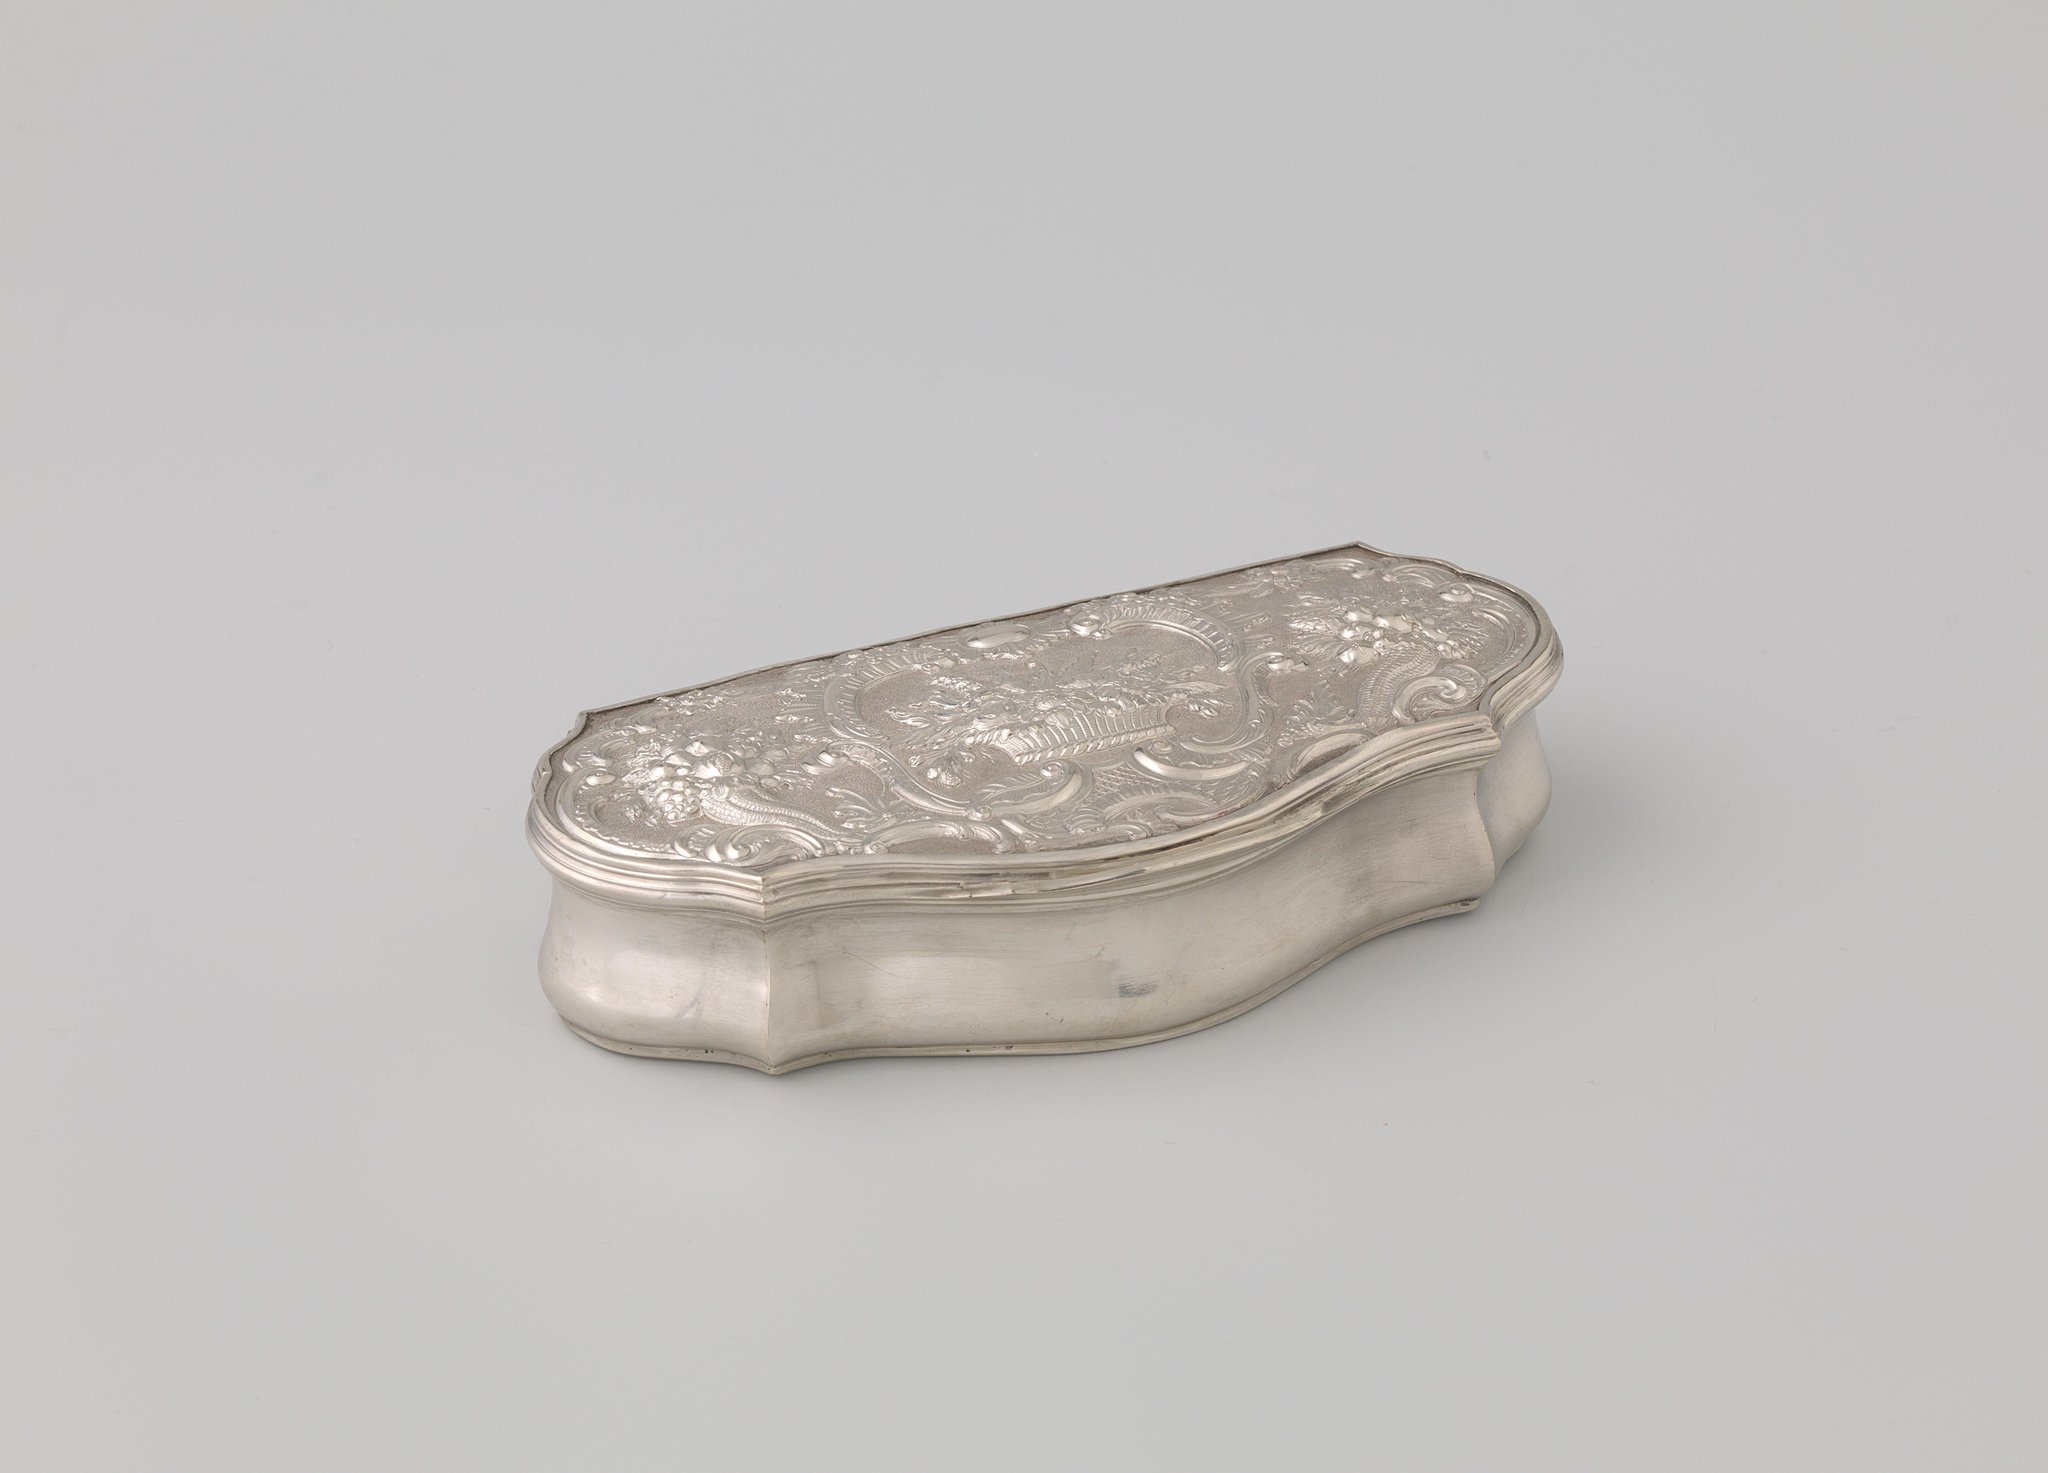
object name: tobacco box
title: Tabaksdoos met op het deksel een gedreven hoorn van overvloed en een bloemenmand tussen ornamenten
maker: pieter de koo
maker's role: silversmith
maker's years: 1724-1786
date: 1765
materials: silver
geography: amsterdam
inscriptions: duty mark, town mark, date letter: ‘F’, maker's mark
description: Tobacco box. Silver. Amsterdam, 1765, attributed to Pieter de Koo.